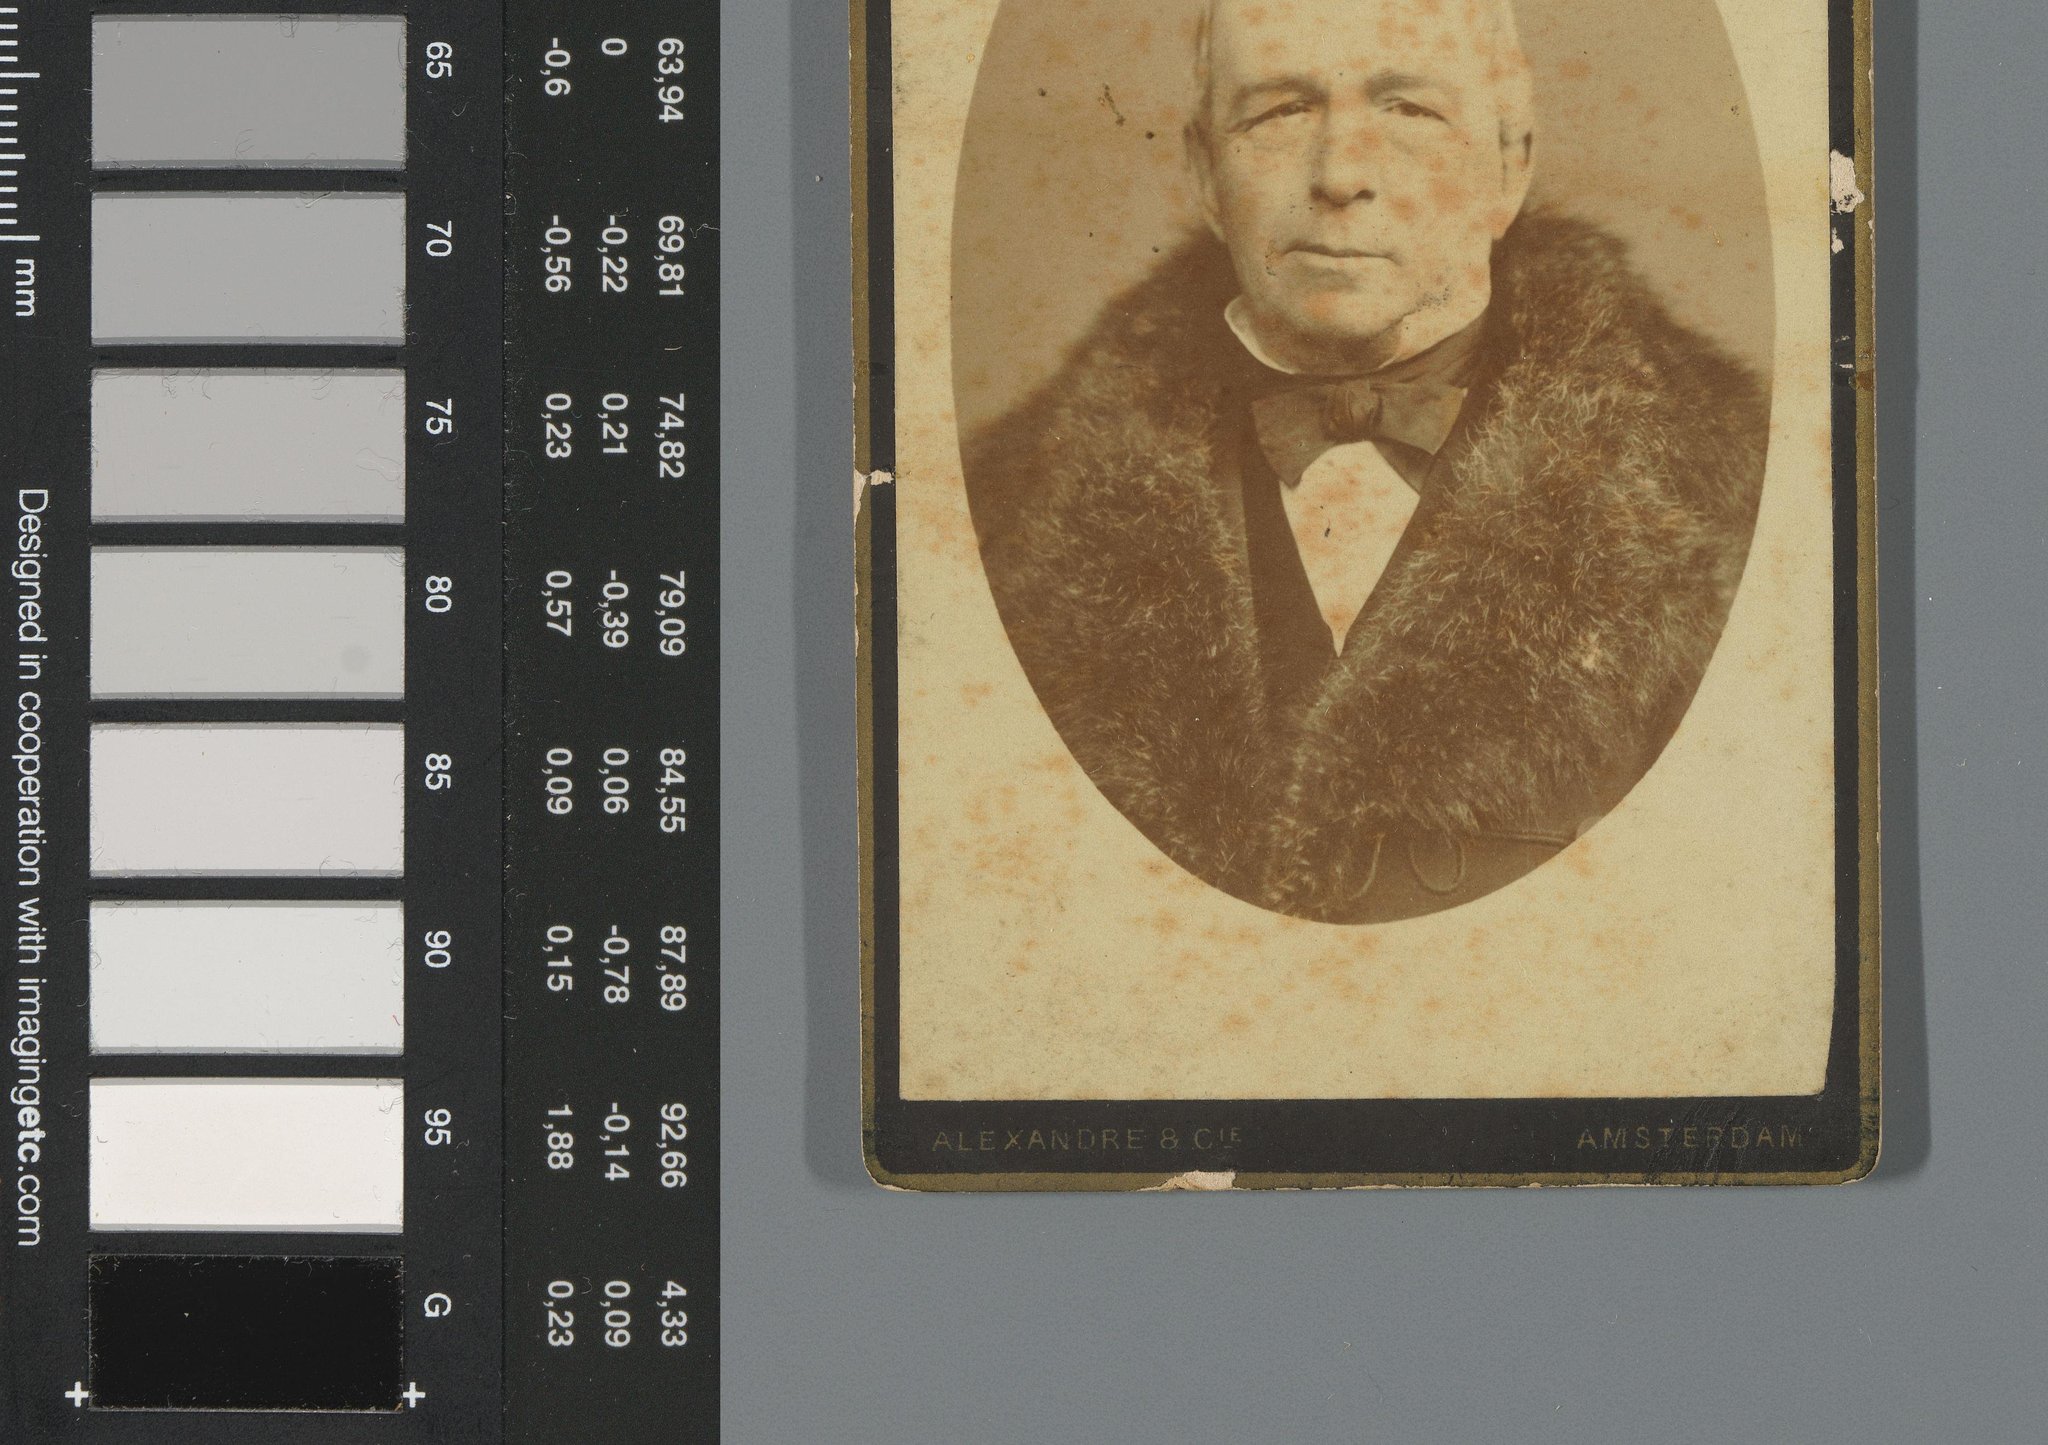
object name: photograph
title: Portret van Jasper Ruysch Lehman de Lehnsfeld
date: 1860-1920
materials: cardboard, photographic support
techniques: photography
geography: amsterdam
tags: historical persons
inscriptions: annotation: ‘Jasper Ruysch Lehman de Lehnsfeld’